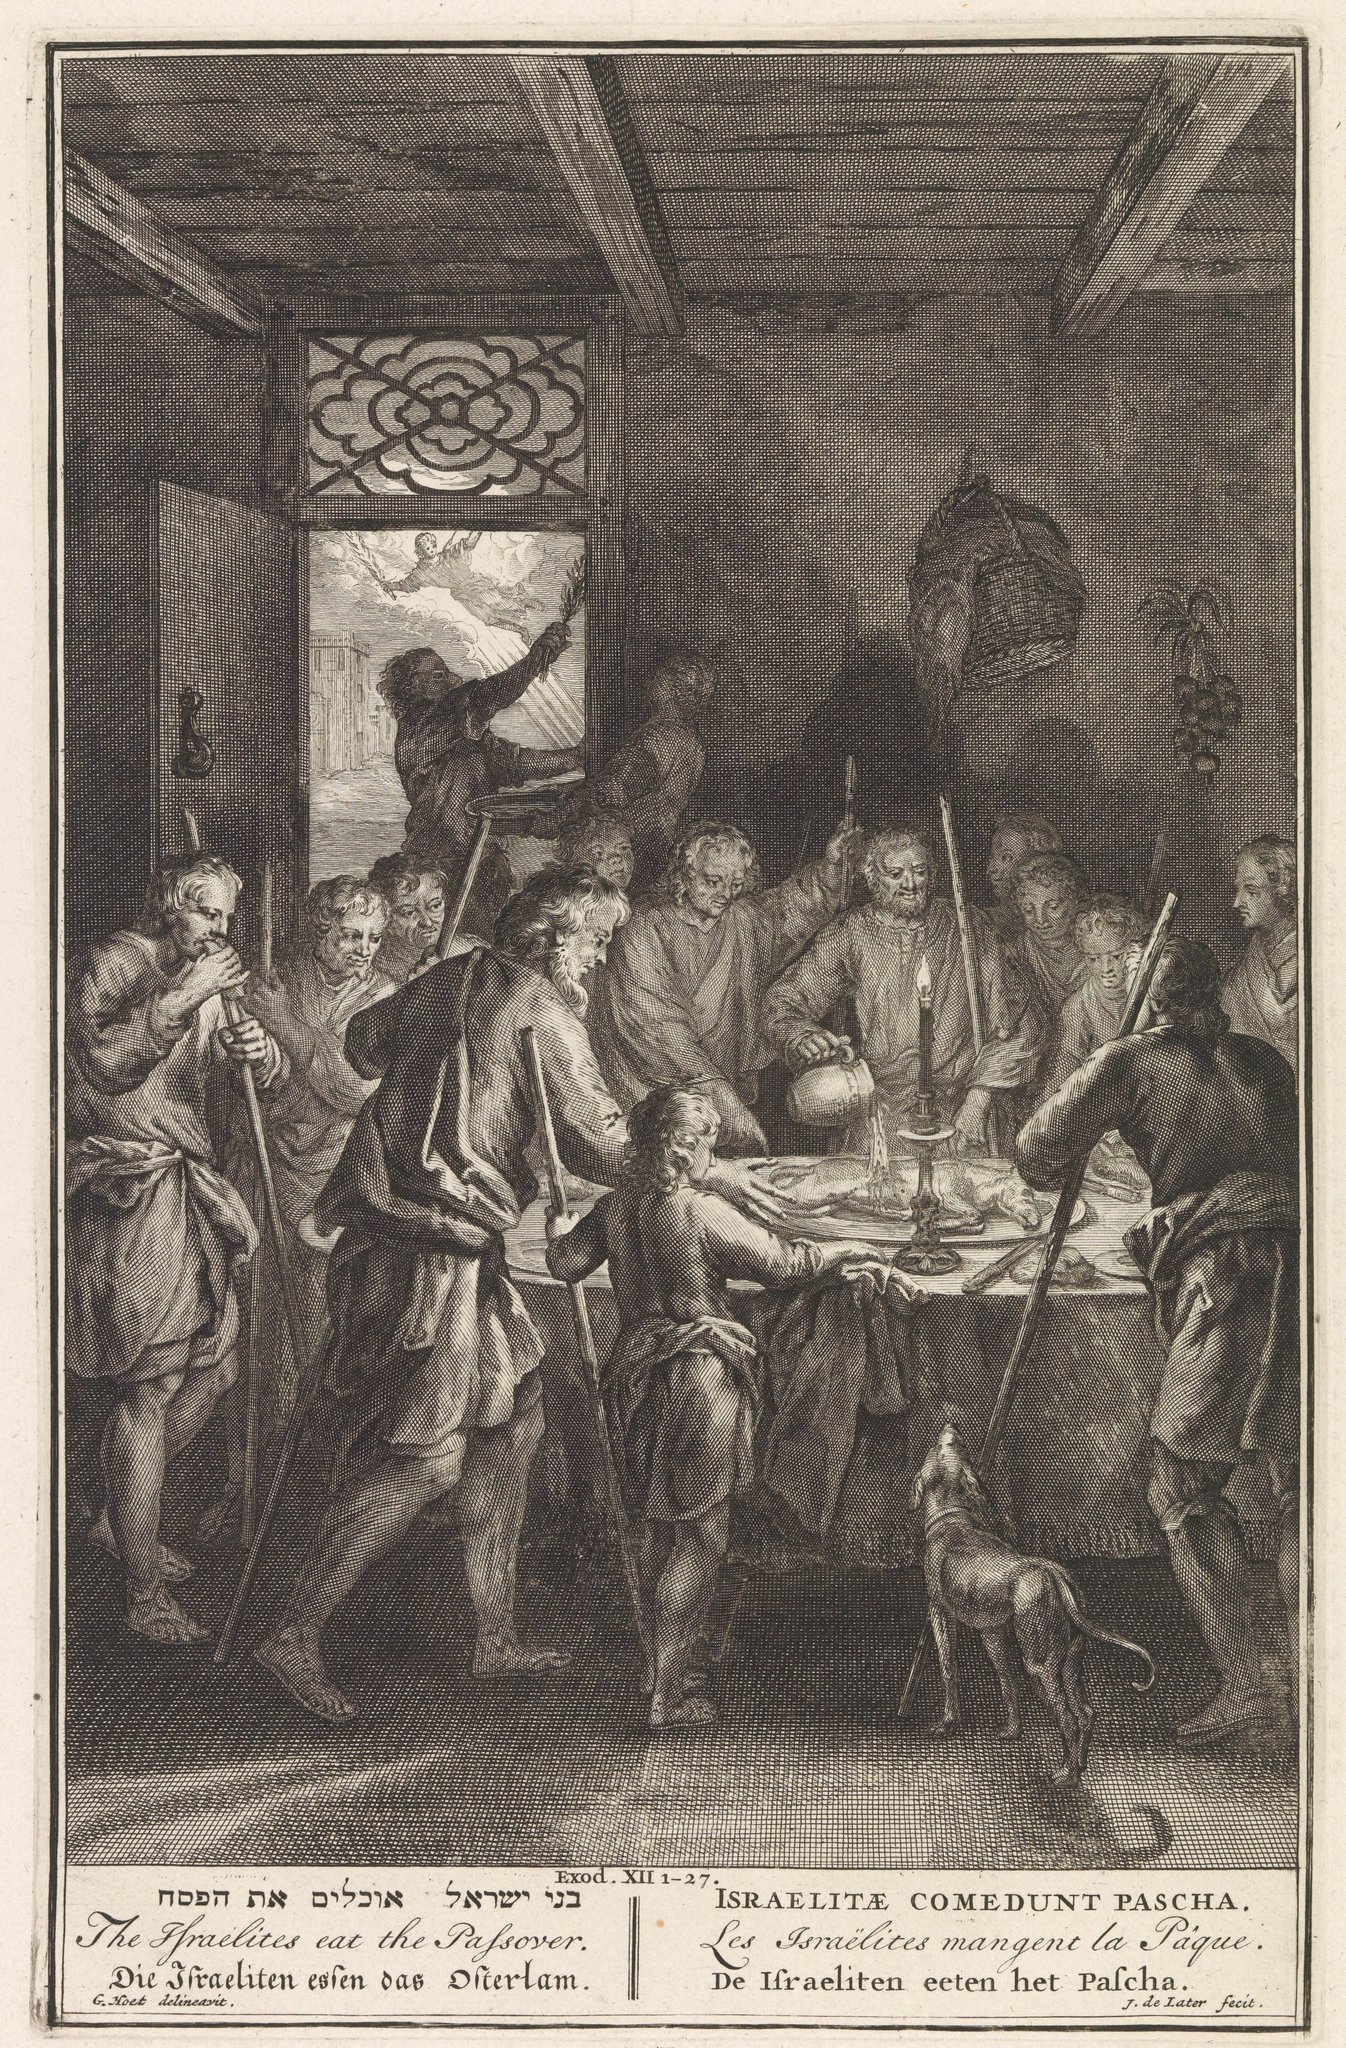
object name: print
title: Paschaviering in Egypte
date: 1728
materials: paper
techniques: engraving, etching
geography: amsterdam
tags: the israelites eat the passover lamb standing about a table with their loins girt, their shoes on their feet and with staves in their hands, ready to depart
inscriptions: collector's mark: Lugt 2228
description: De Israëlieten staan rond een tafel en eten haastig het lam. Met schoenen aan hun voeten, de lendelen omgord en stokken in hun handen zijn ze klaar om te vertekken uit hun ballingschap. Op de achtergrond wordt op de deurpost een teken met bloed aangebracht. Bijbelse voorstelling uit Ex. 12:1-27 met in de marge de titel van de voorstelling in zes talen.